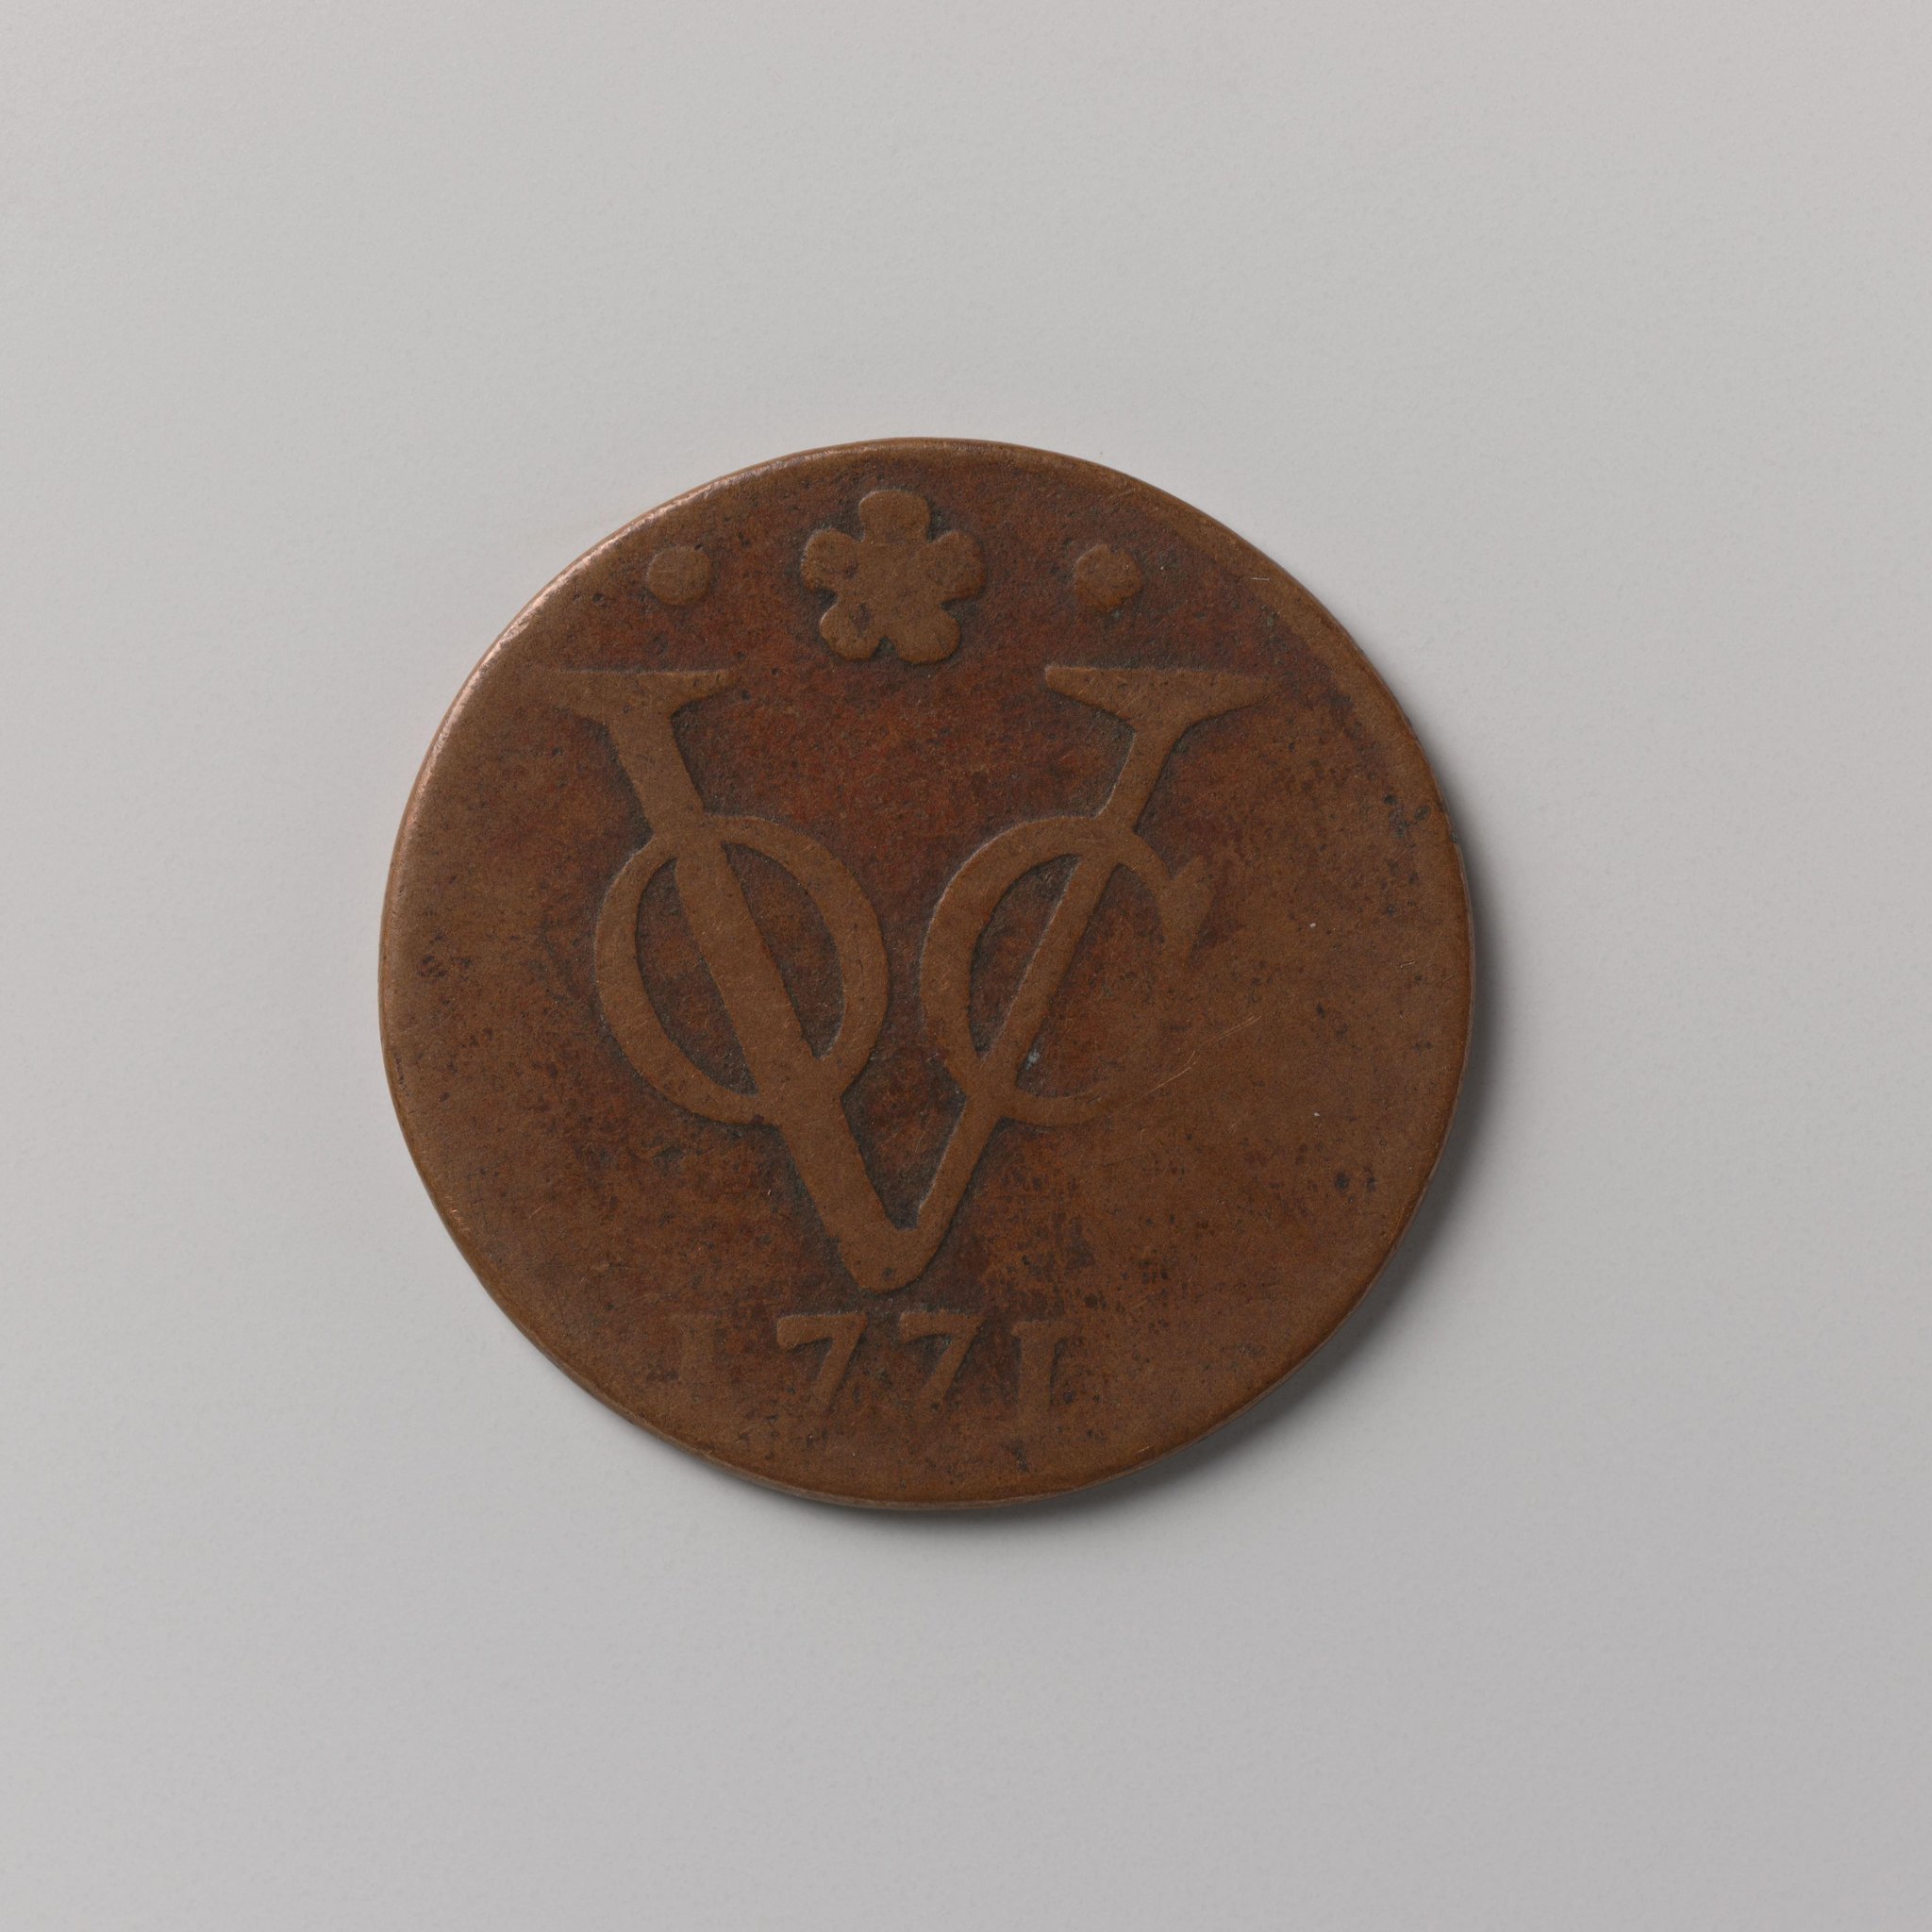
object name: coin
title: VOC, duit Holland, 1771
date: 1771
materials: copper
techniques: striking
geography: dordrecht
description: Koperen munt. Voorzijde: gekroond wapenschild van Holland. Keerzijde: monogram van de VOC, waarboven muntteken en waaronder jaartal. Gladde rand.